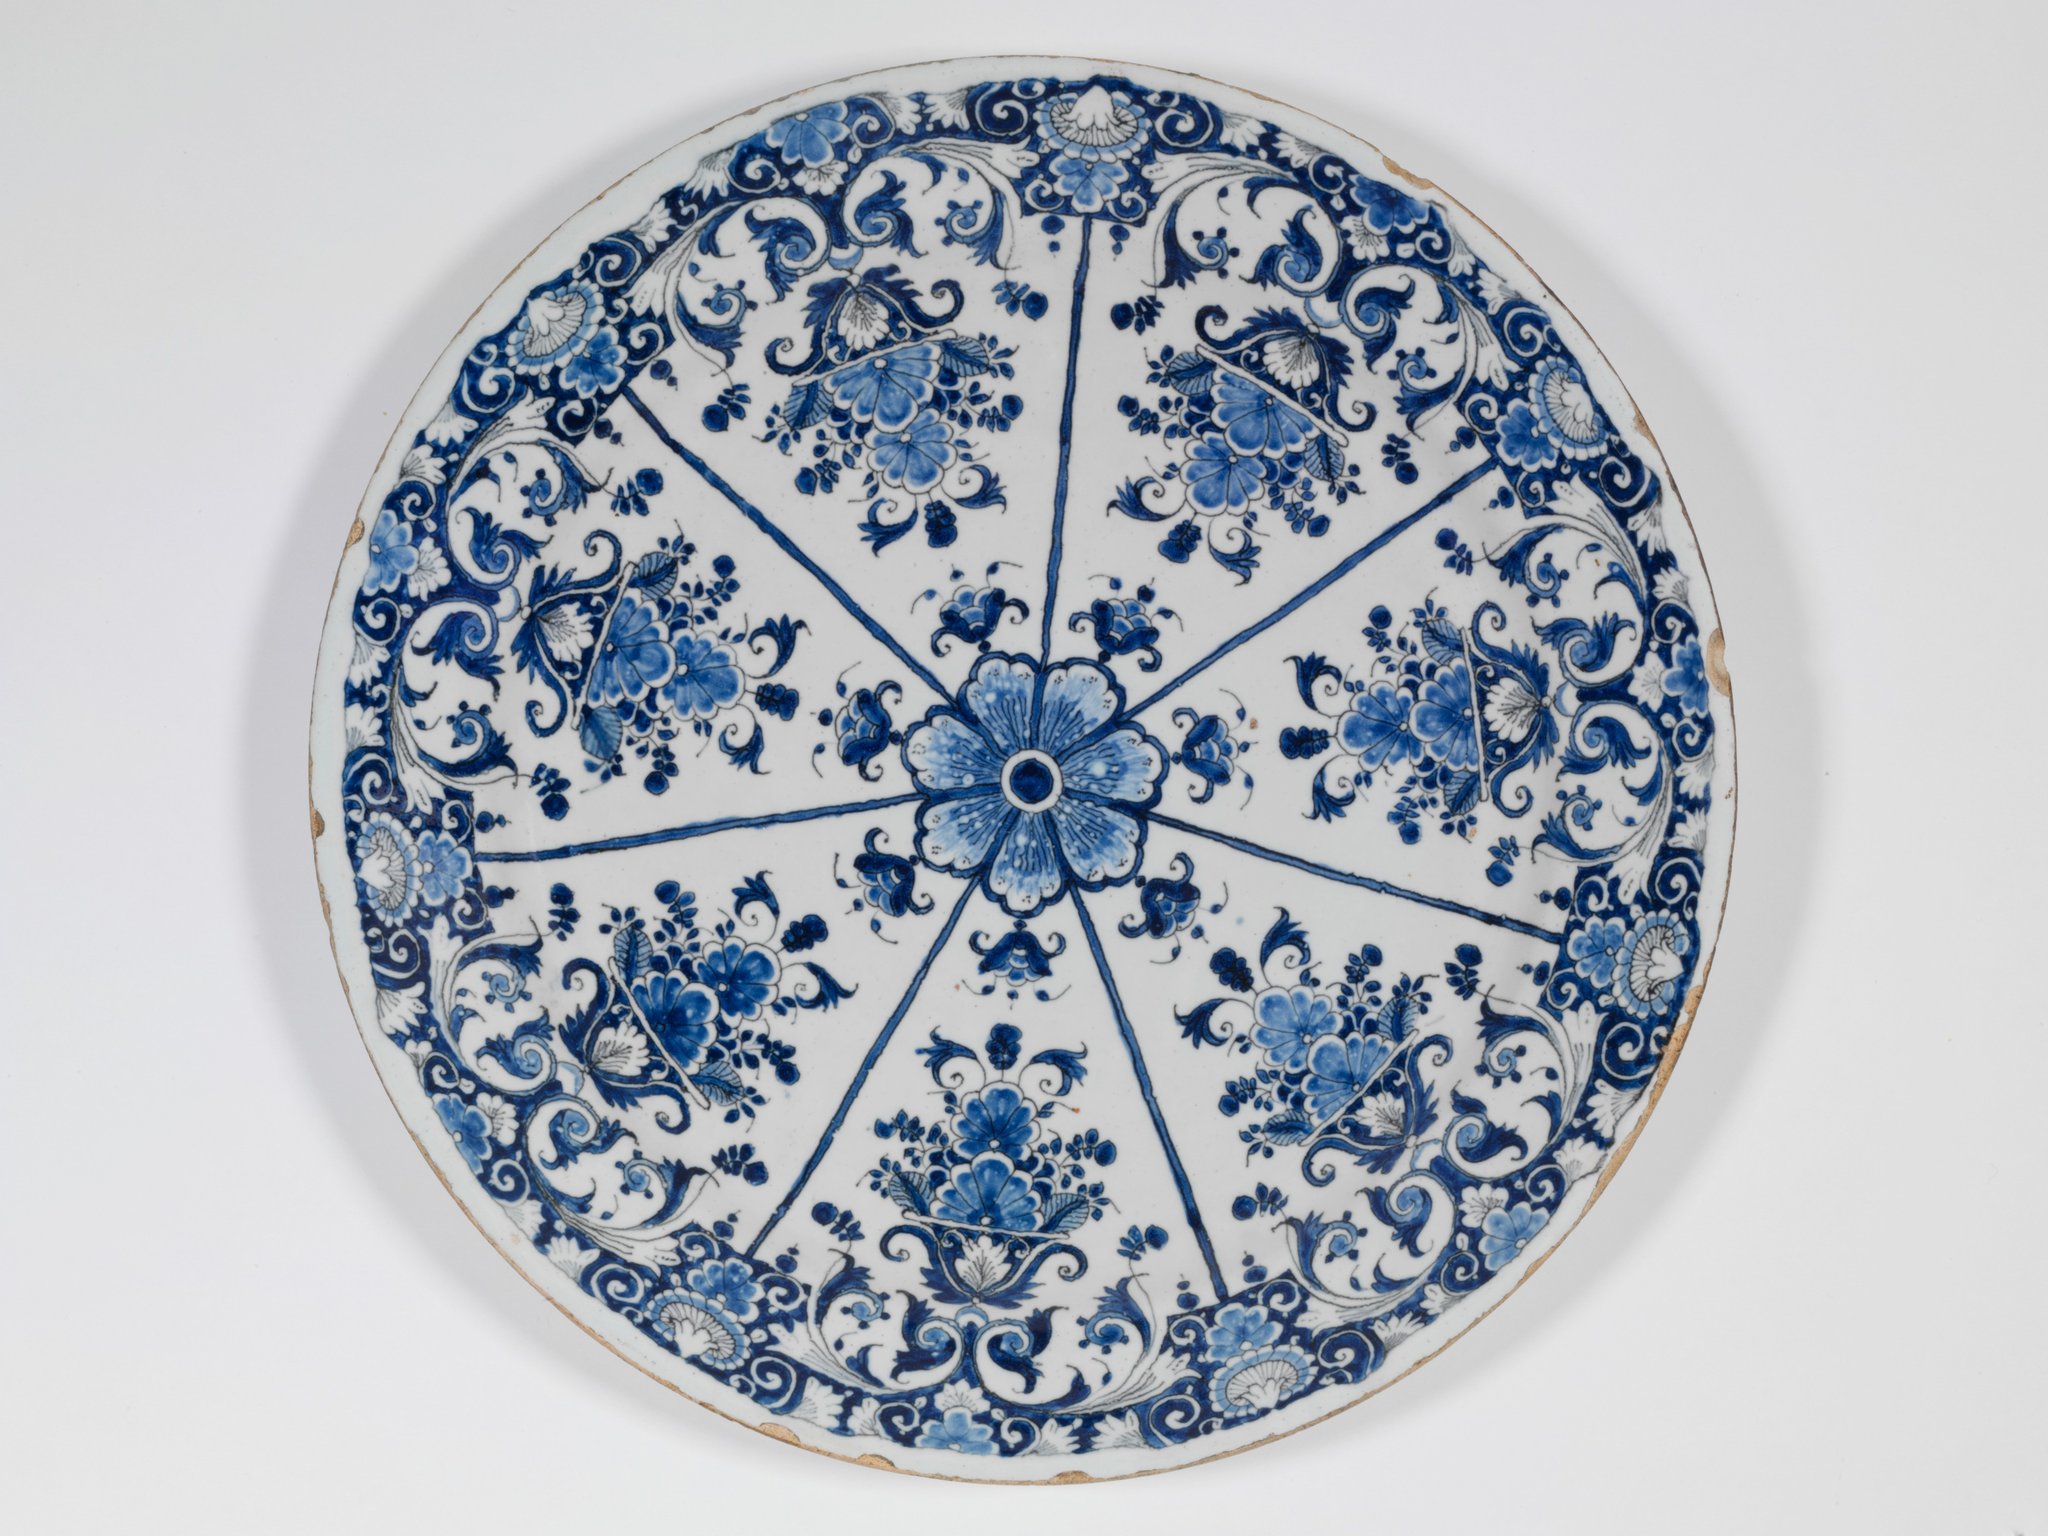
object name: plate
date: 1720-1730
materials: faience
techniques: glazing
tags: flowers